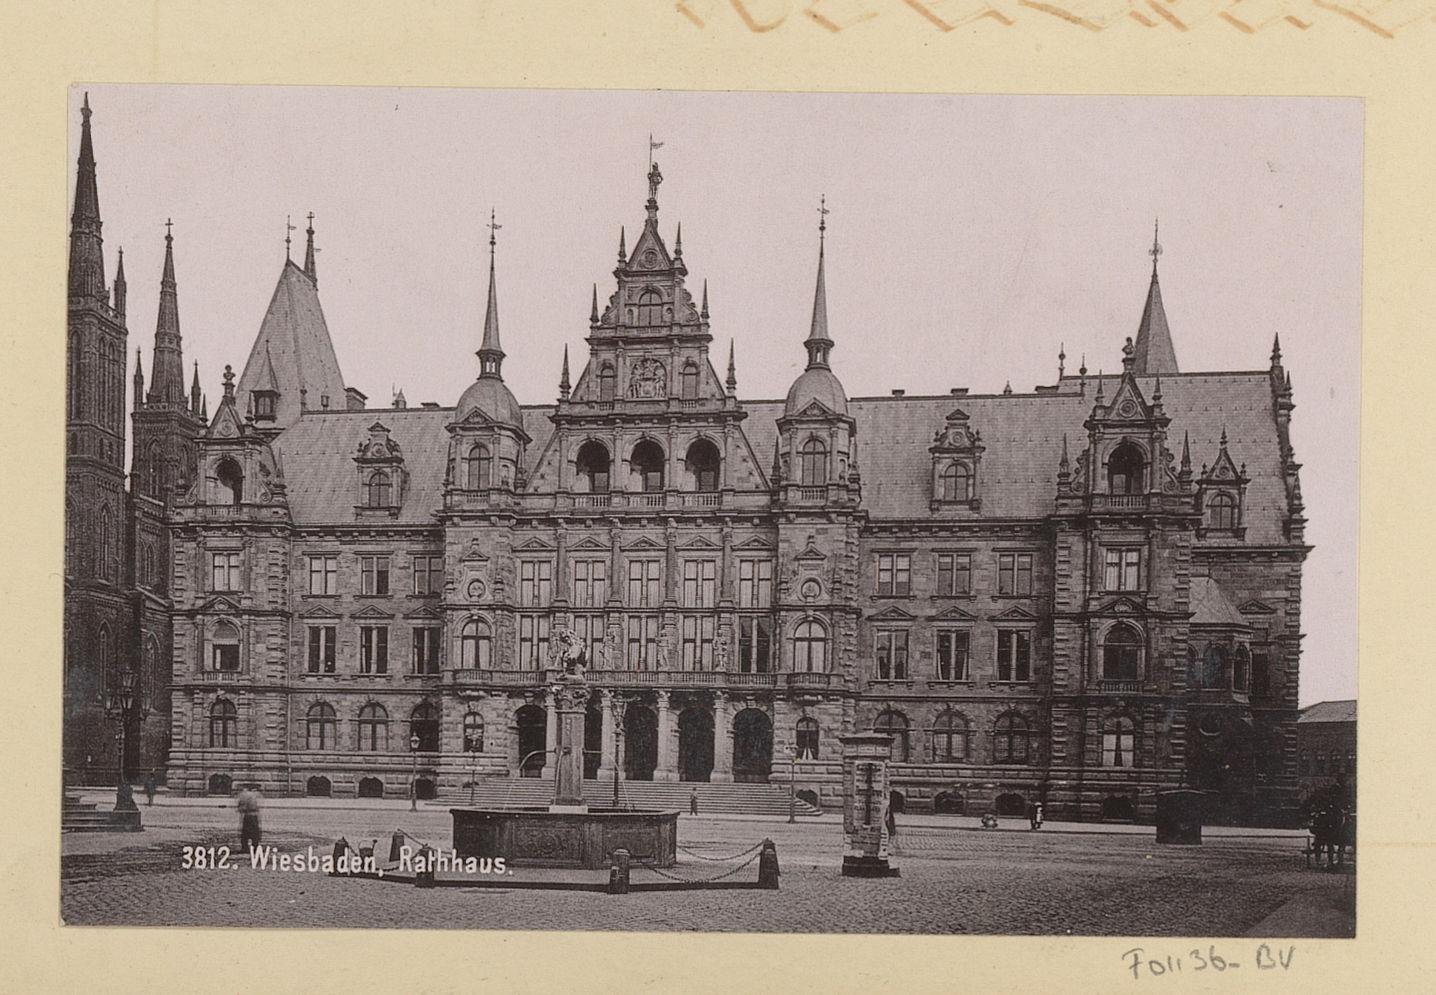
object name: photomechanical print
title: Exterieur van het stadhuis van Wiesbaden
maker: Anonymous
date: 1887-1895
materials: paper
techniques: photograph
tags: townhall, façade (of house or building)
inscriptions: number: ‘3812’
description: Onderdeel van Fotoalbum met opnames van bezienswaardigheden in België, Duitsland en Noorwegen.